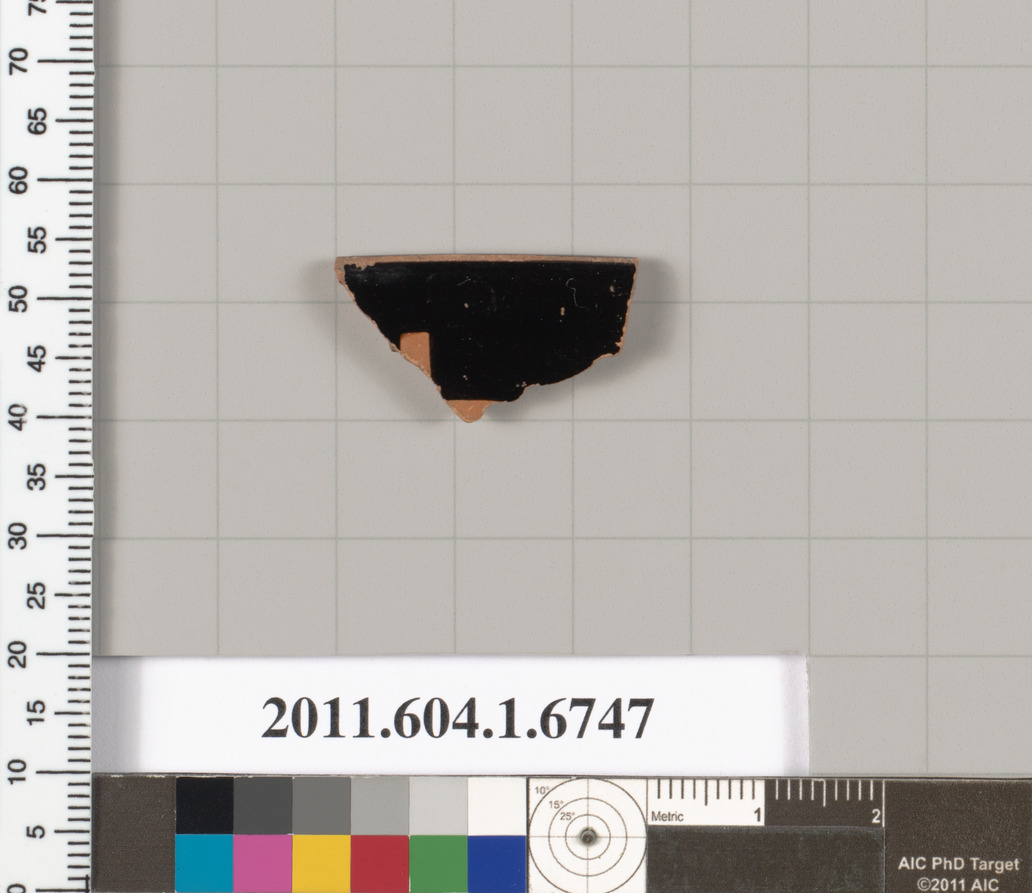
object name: kylix fragment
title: Terracotta rim fragment of a kylix (drinking cup)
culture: greek, attic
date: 490-470 BCE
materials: terracotta